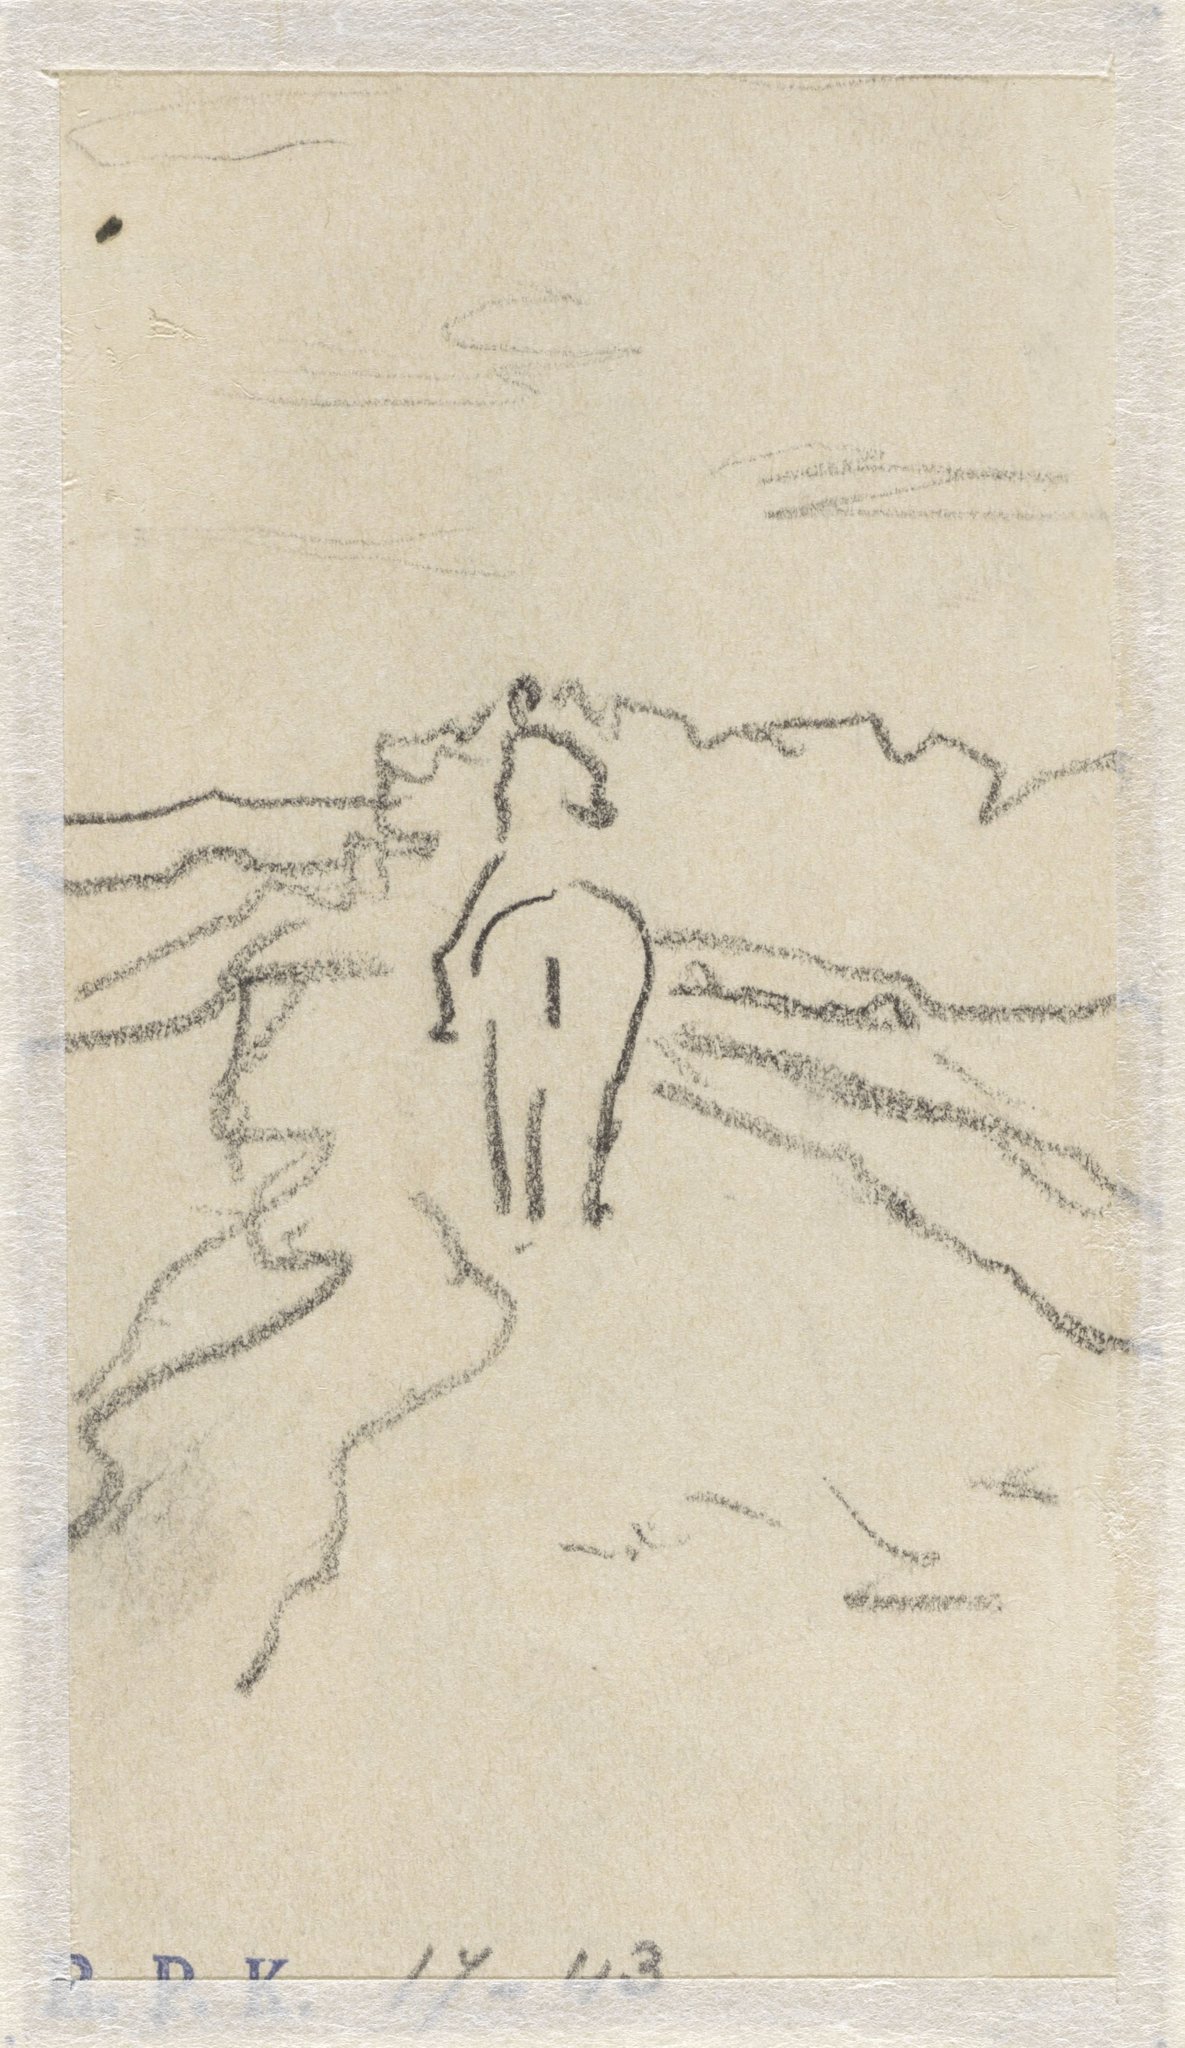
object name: drawing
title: Landschap met ruiter, van achteren gezien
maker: anton mauve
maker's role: draughtsman, painter, print maker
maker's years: 1838-1888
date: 1848-1888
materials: chalk, paper